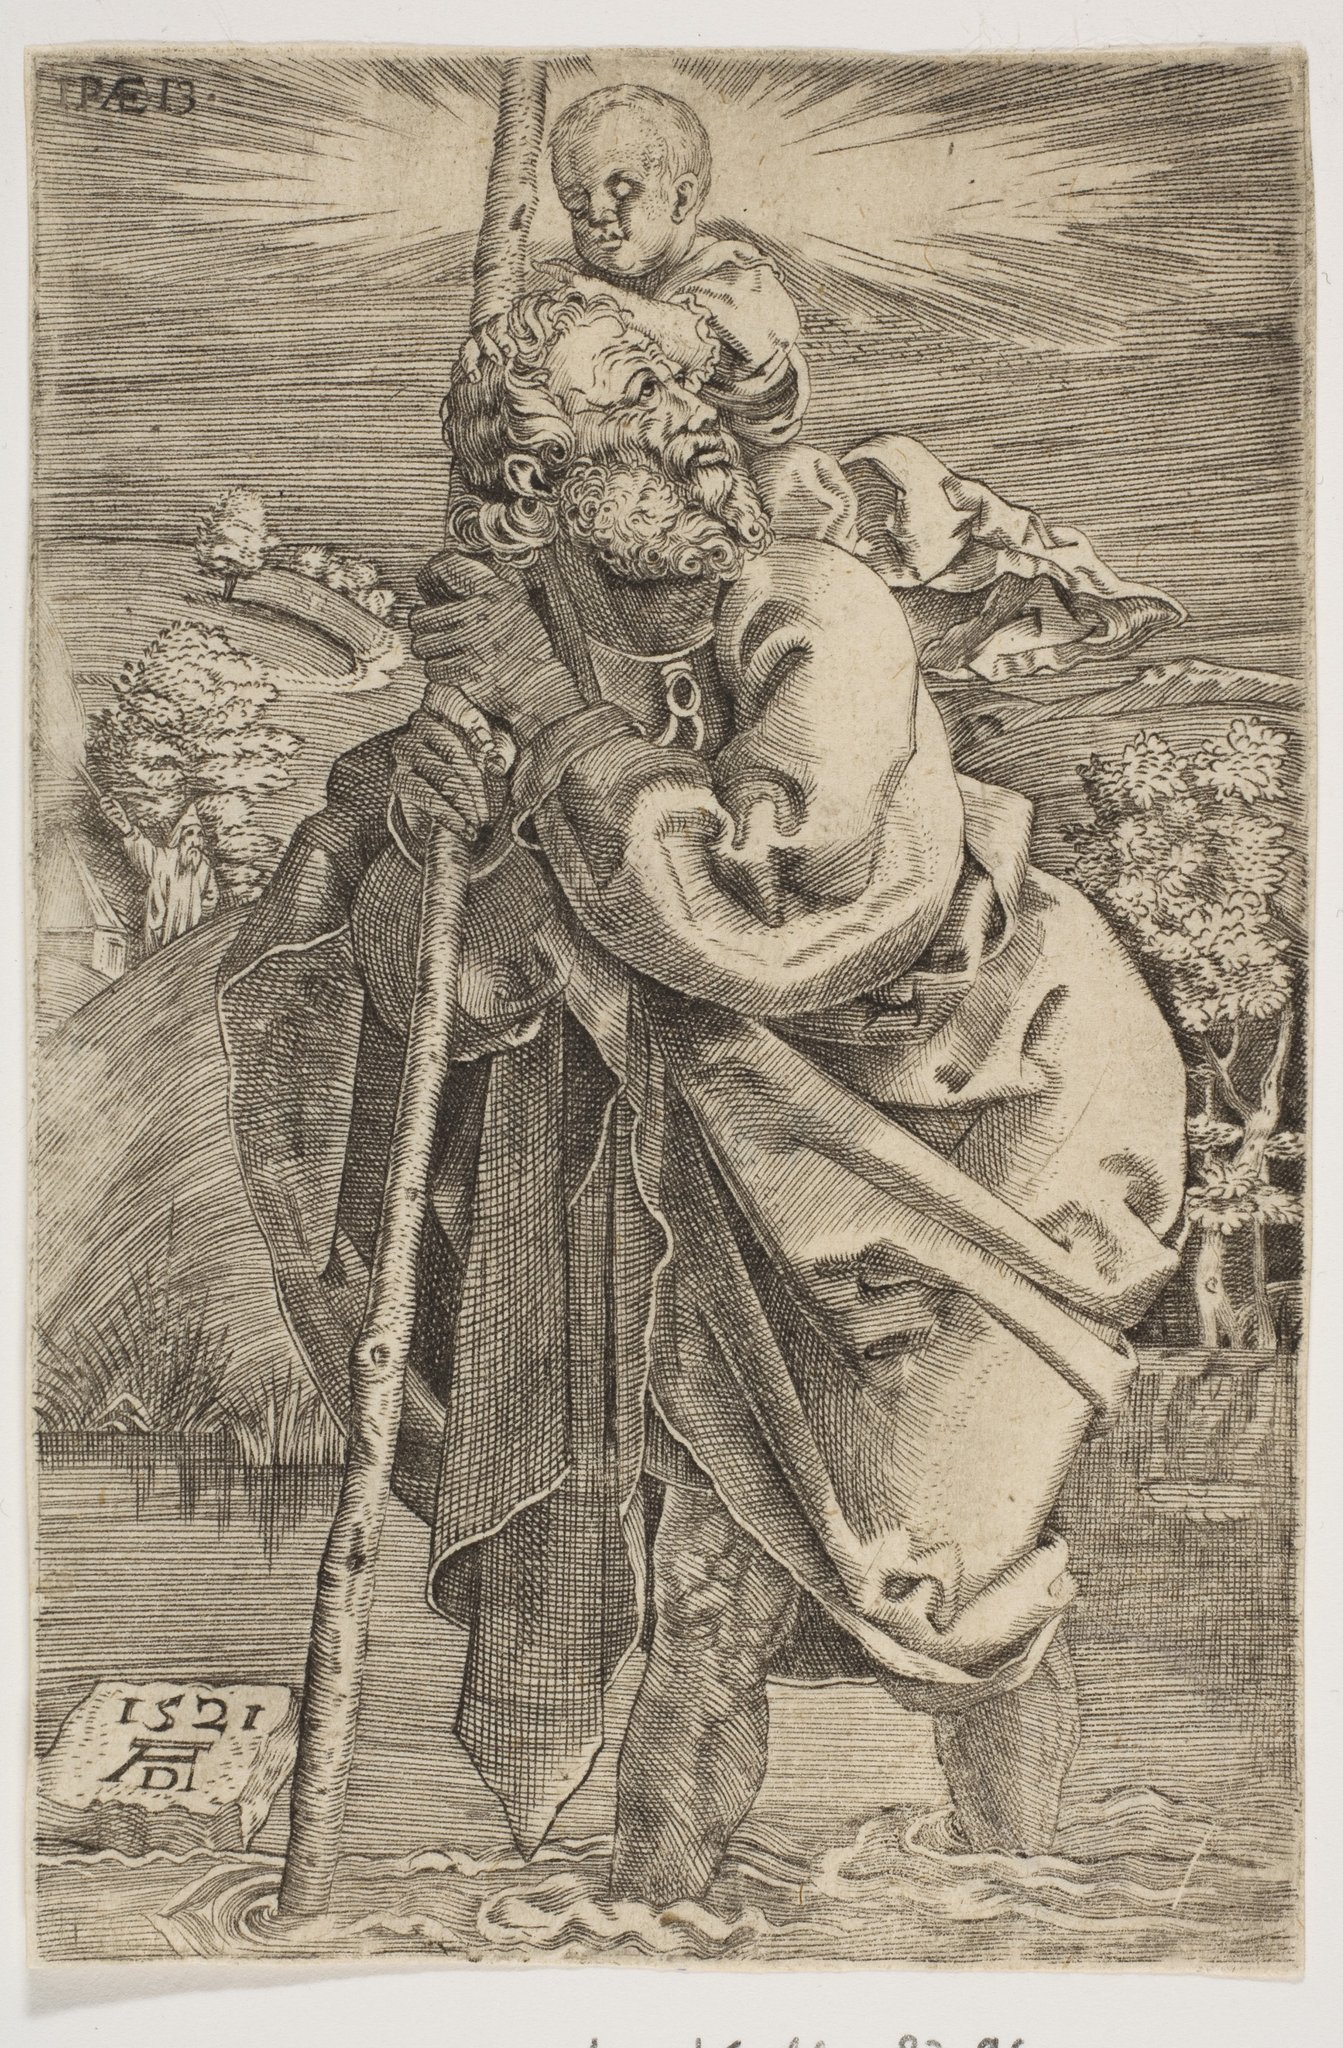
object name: print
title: Saint Christopher Facing Left (reverse copy)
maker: albrecht dürer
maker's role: artist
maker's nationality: german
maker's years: 1471-1528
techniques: engraving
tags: christ,saint christopher